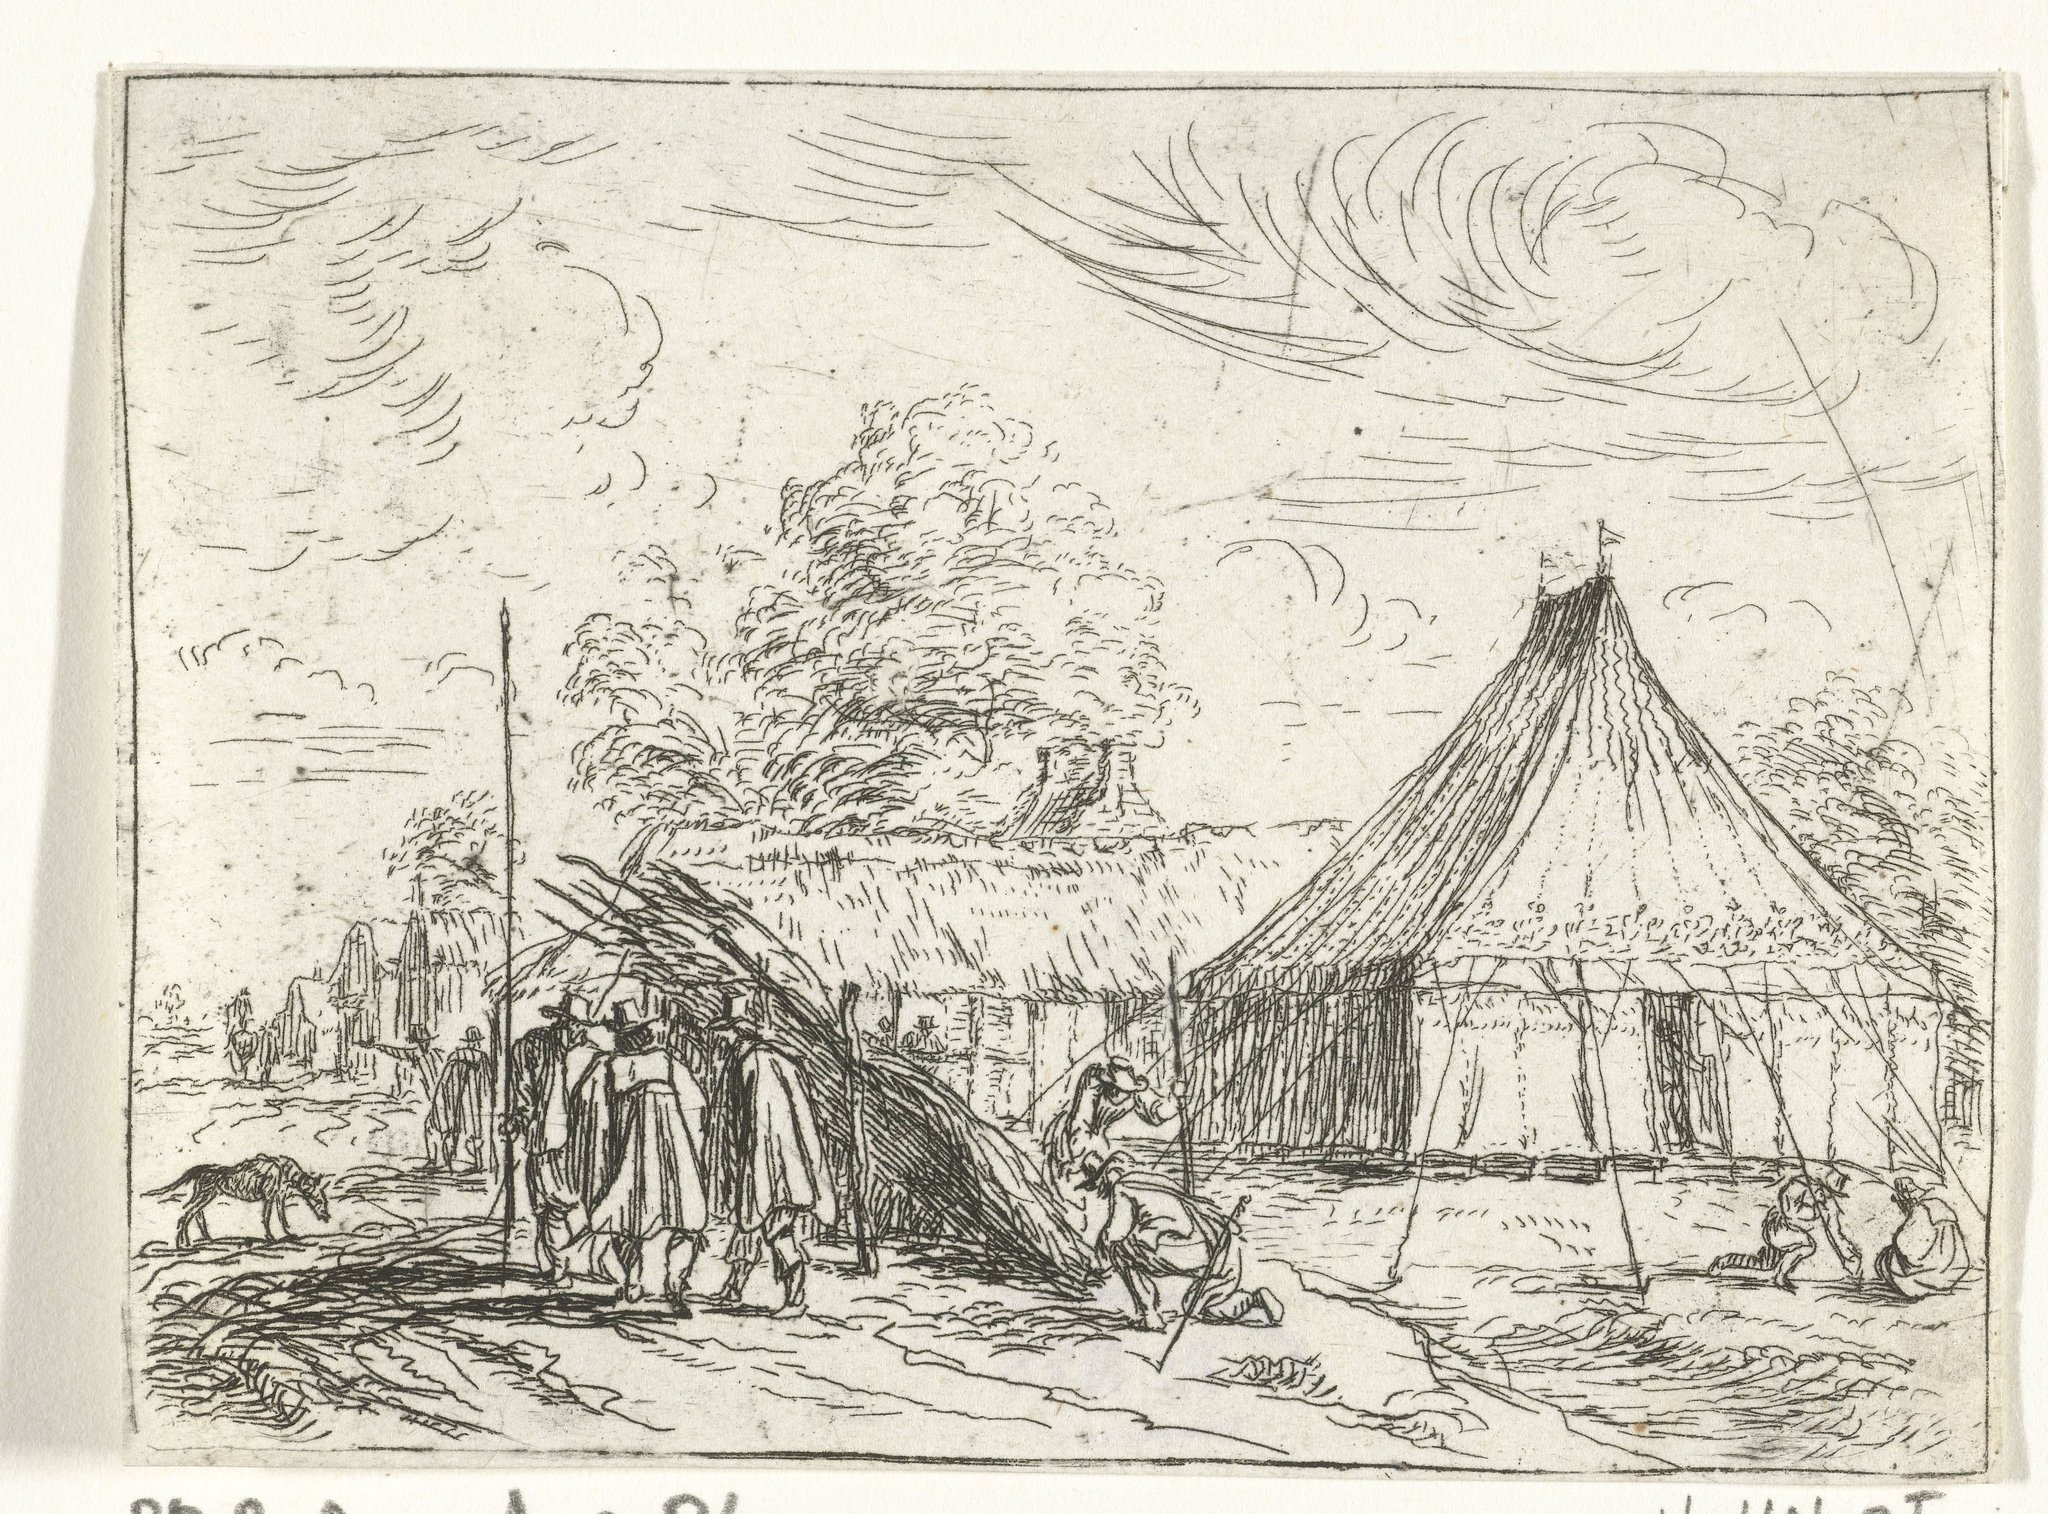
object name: print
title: Landschappen met kampementen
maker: robert van den hoecke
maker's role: draughtsman, painter, print maker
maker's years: 1622-1668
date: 1632-1668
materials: paper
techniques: etching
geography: southern netherlands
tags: tent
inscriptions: collector's mark: Lugt 2228